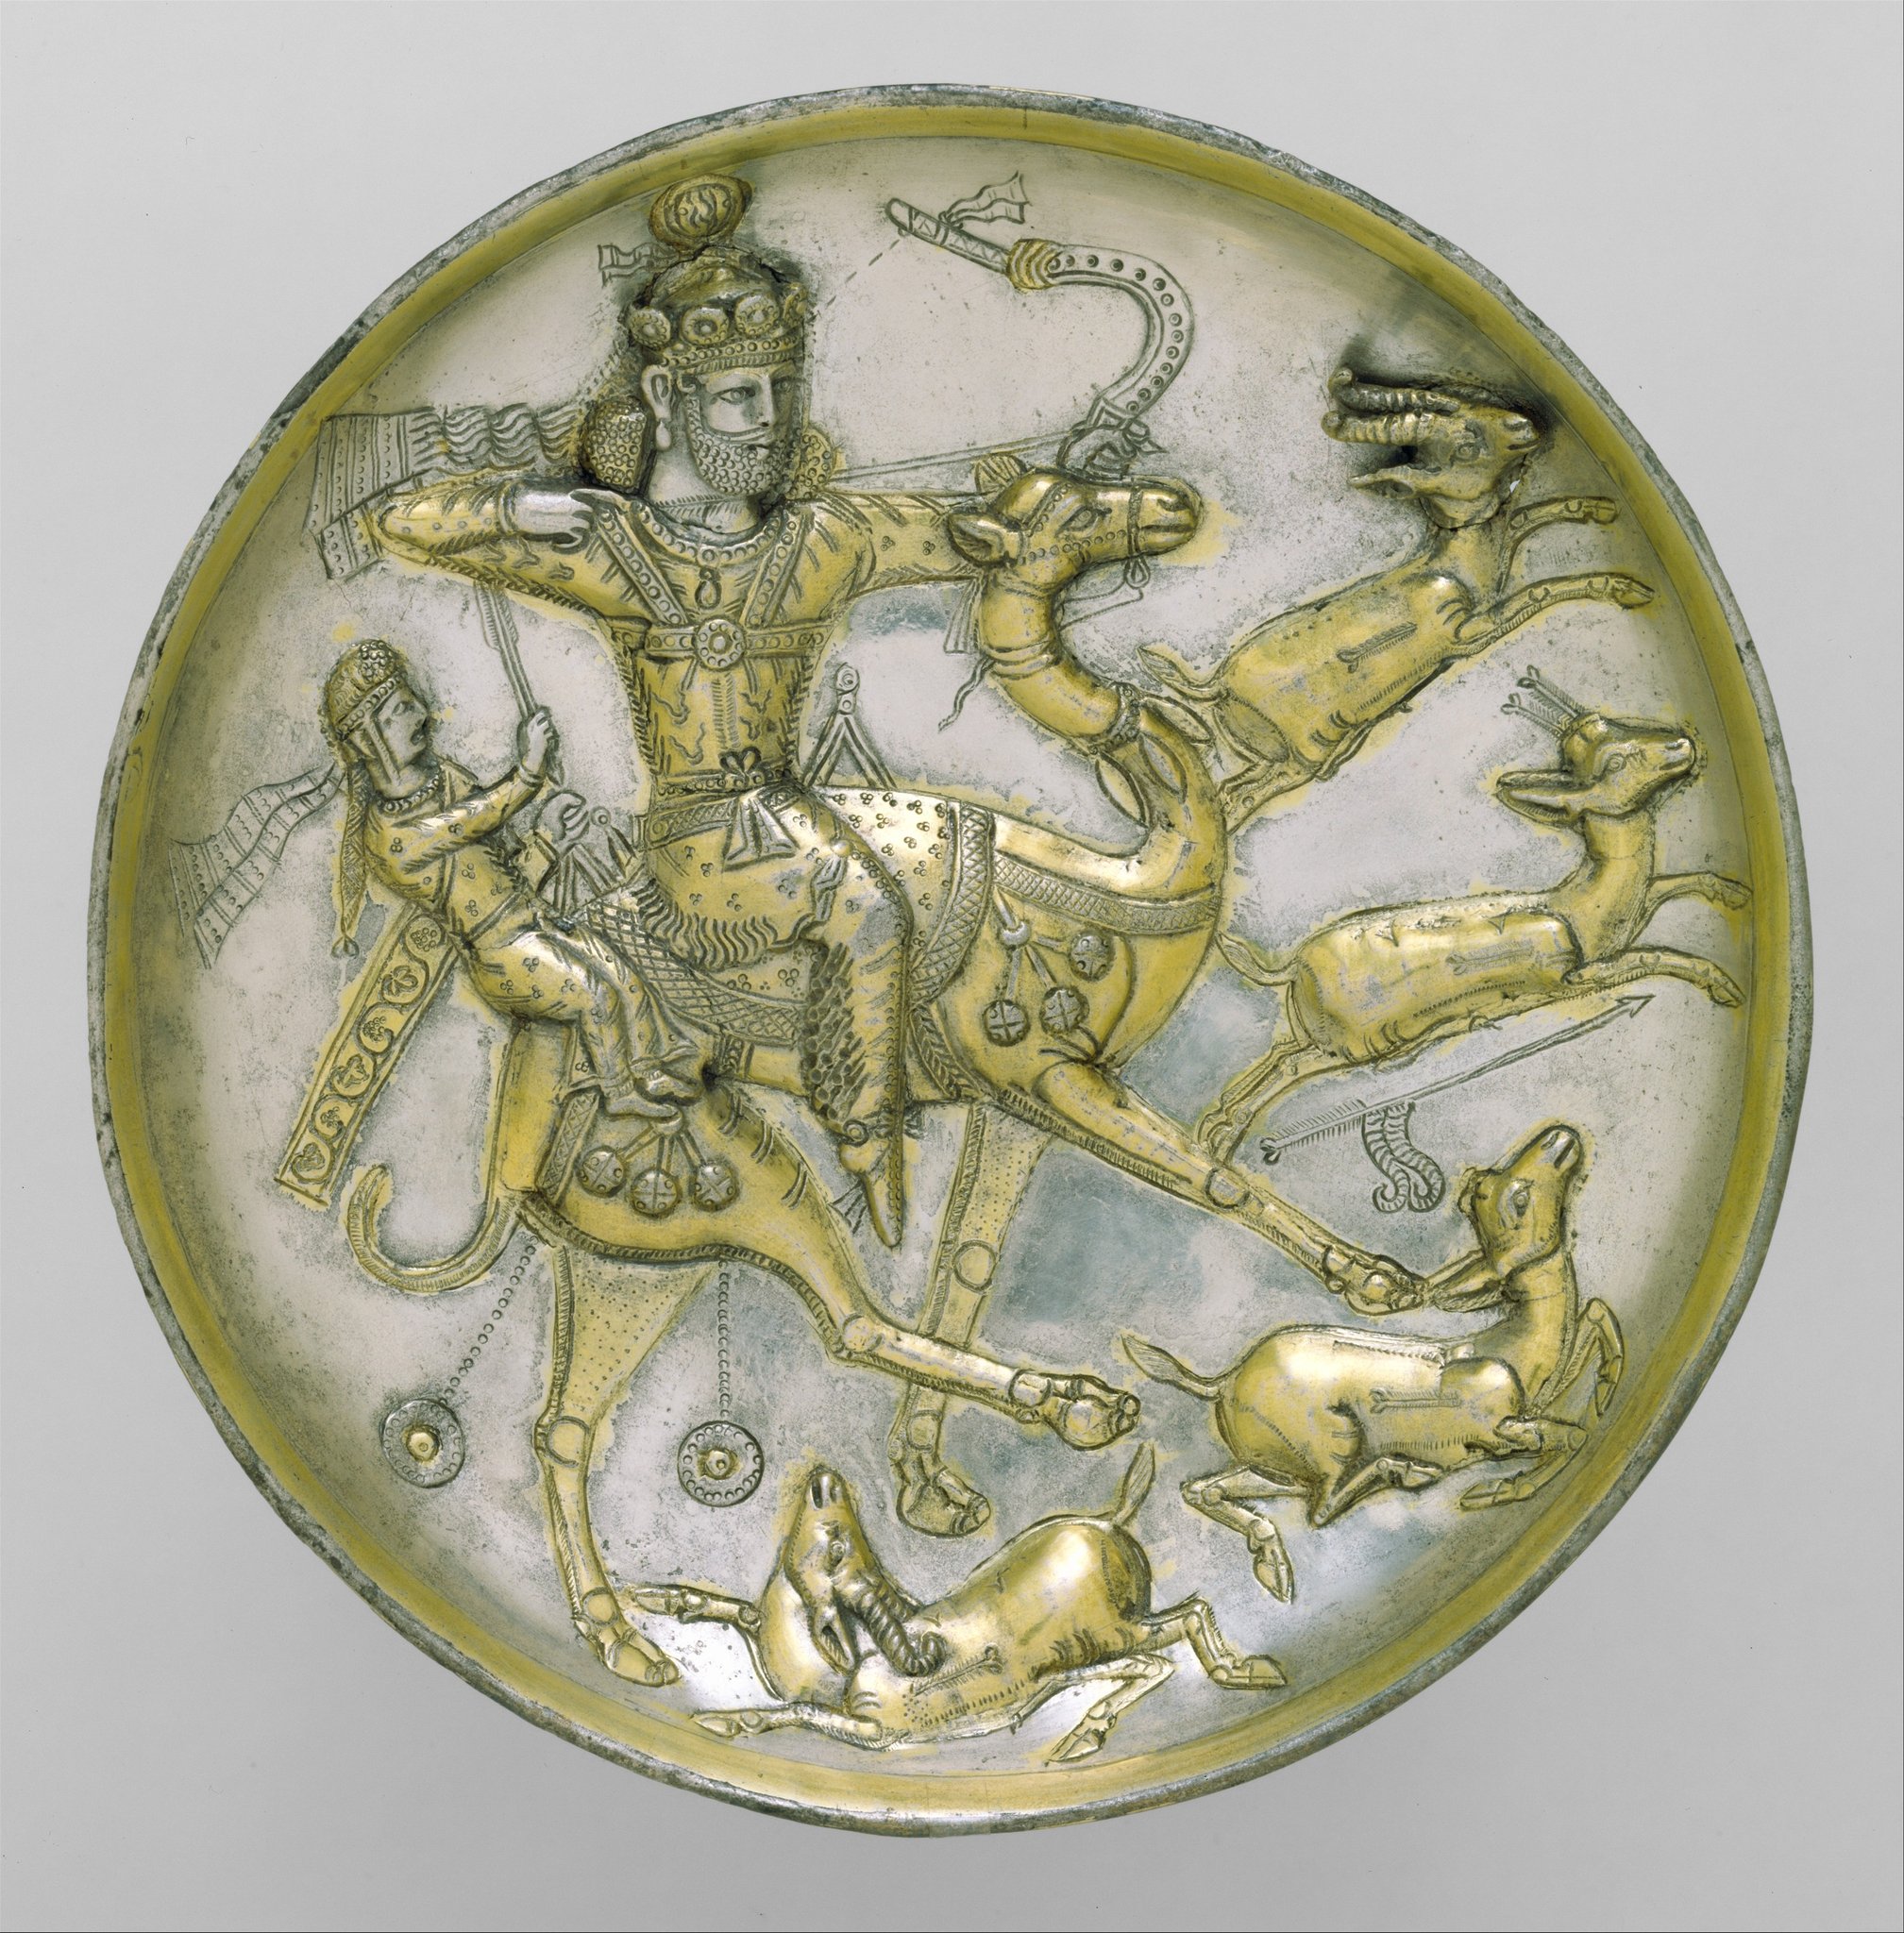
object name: plate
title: Plate with a hunting scene from the tale of Bahram Gur and Azadeh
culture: sasanian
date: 401-500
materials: mercury, silver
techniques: gilding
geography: iran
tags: animals,men,hunting,camels